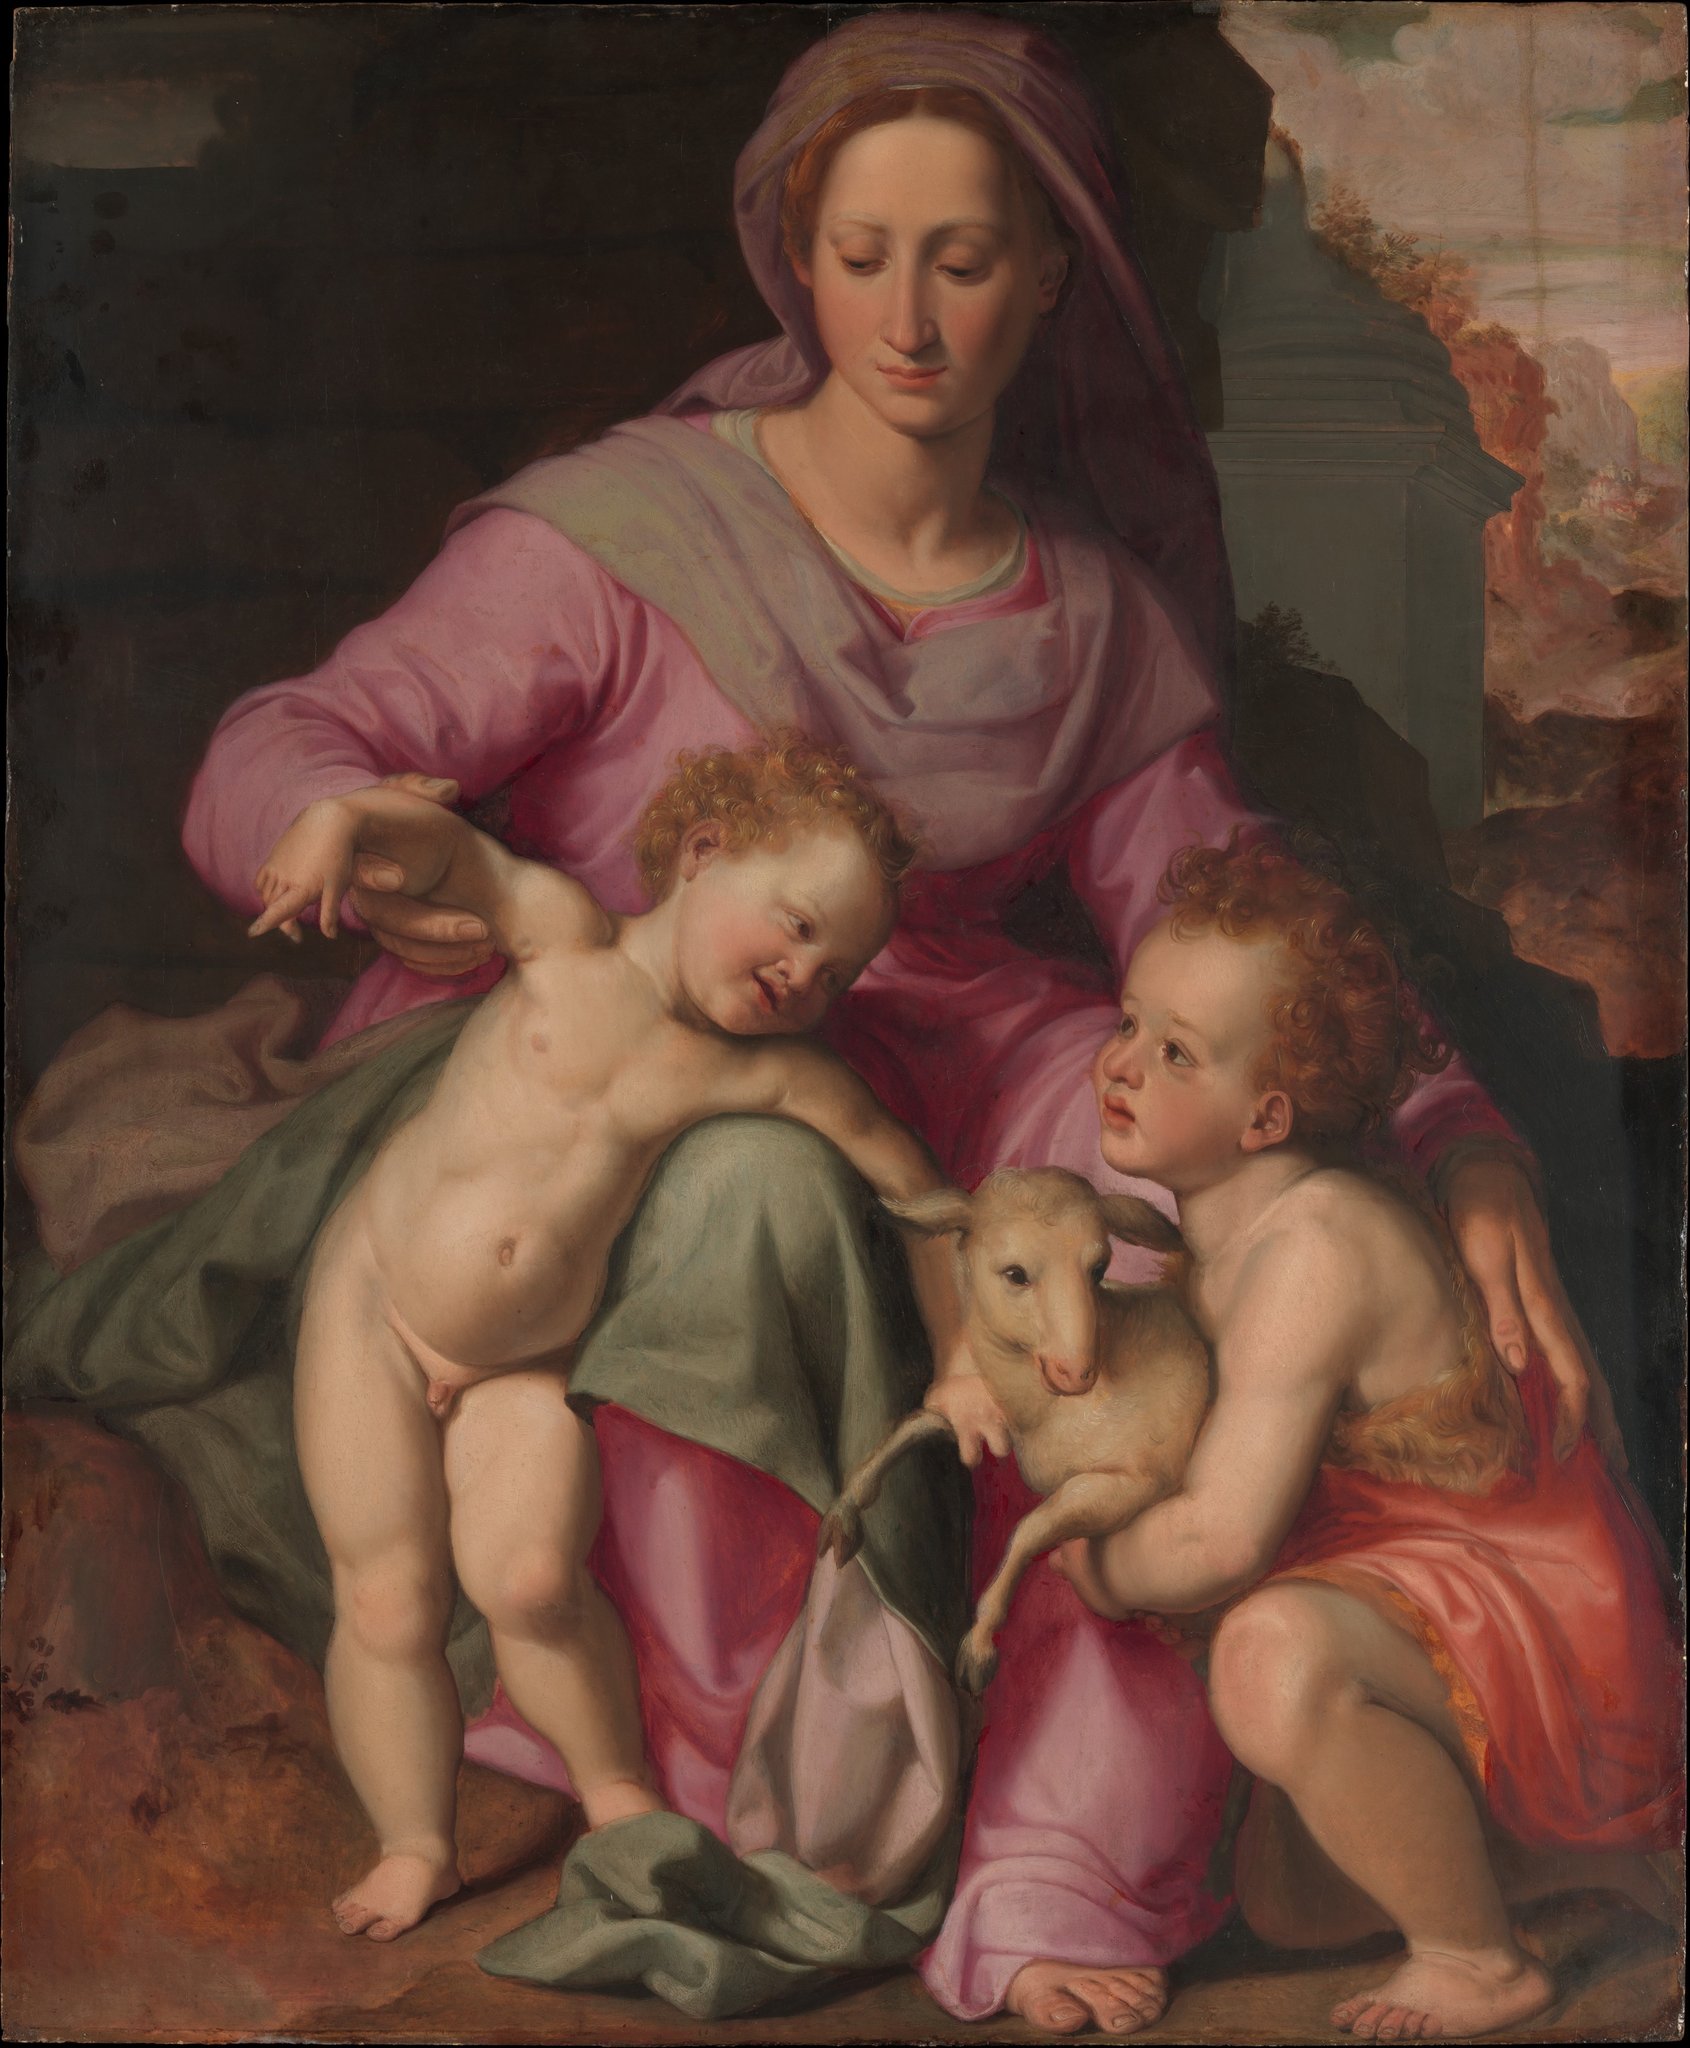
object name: painting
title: Madonna and Child with the Infant Saint John the Baptist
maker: santi di tito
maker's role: artist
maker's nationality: italian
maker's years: 1536-1603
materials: oil, wood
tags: sheep,madonna and child,saint john the baptist